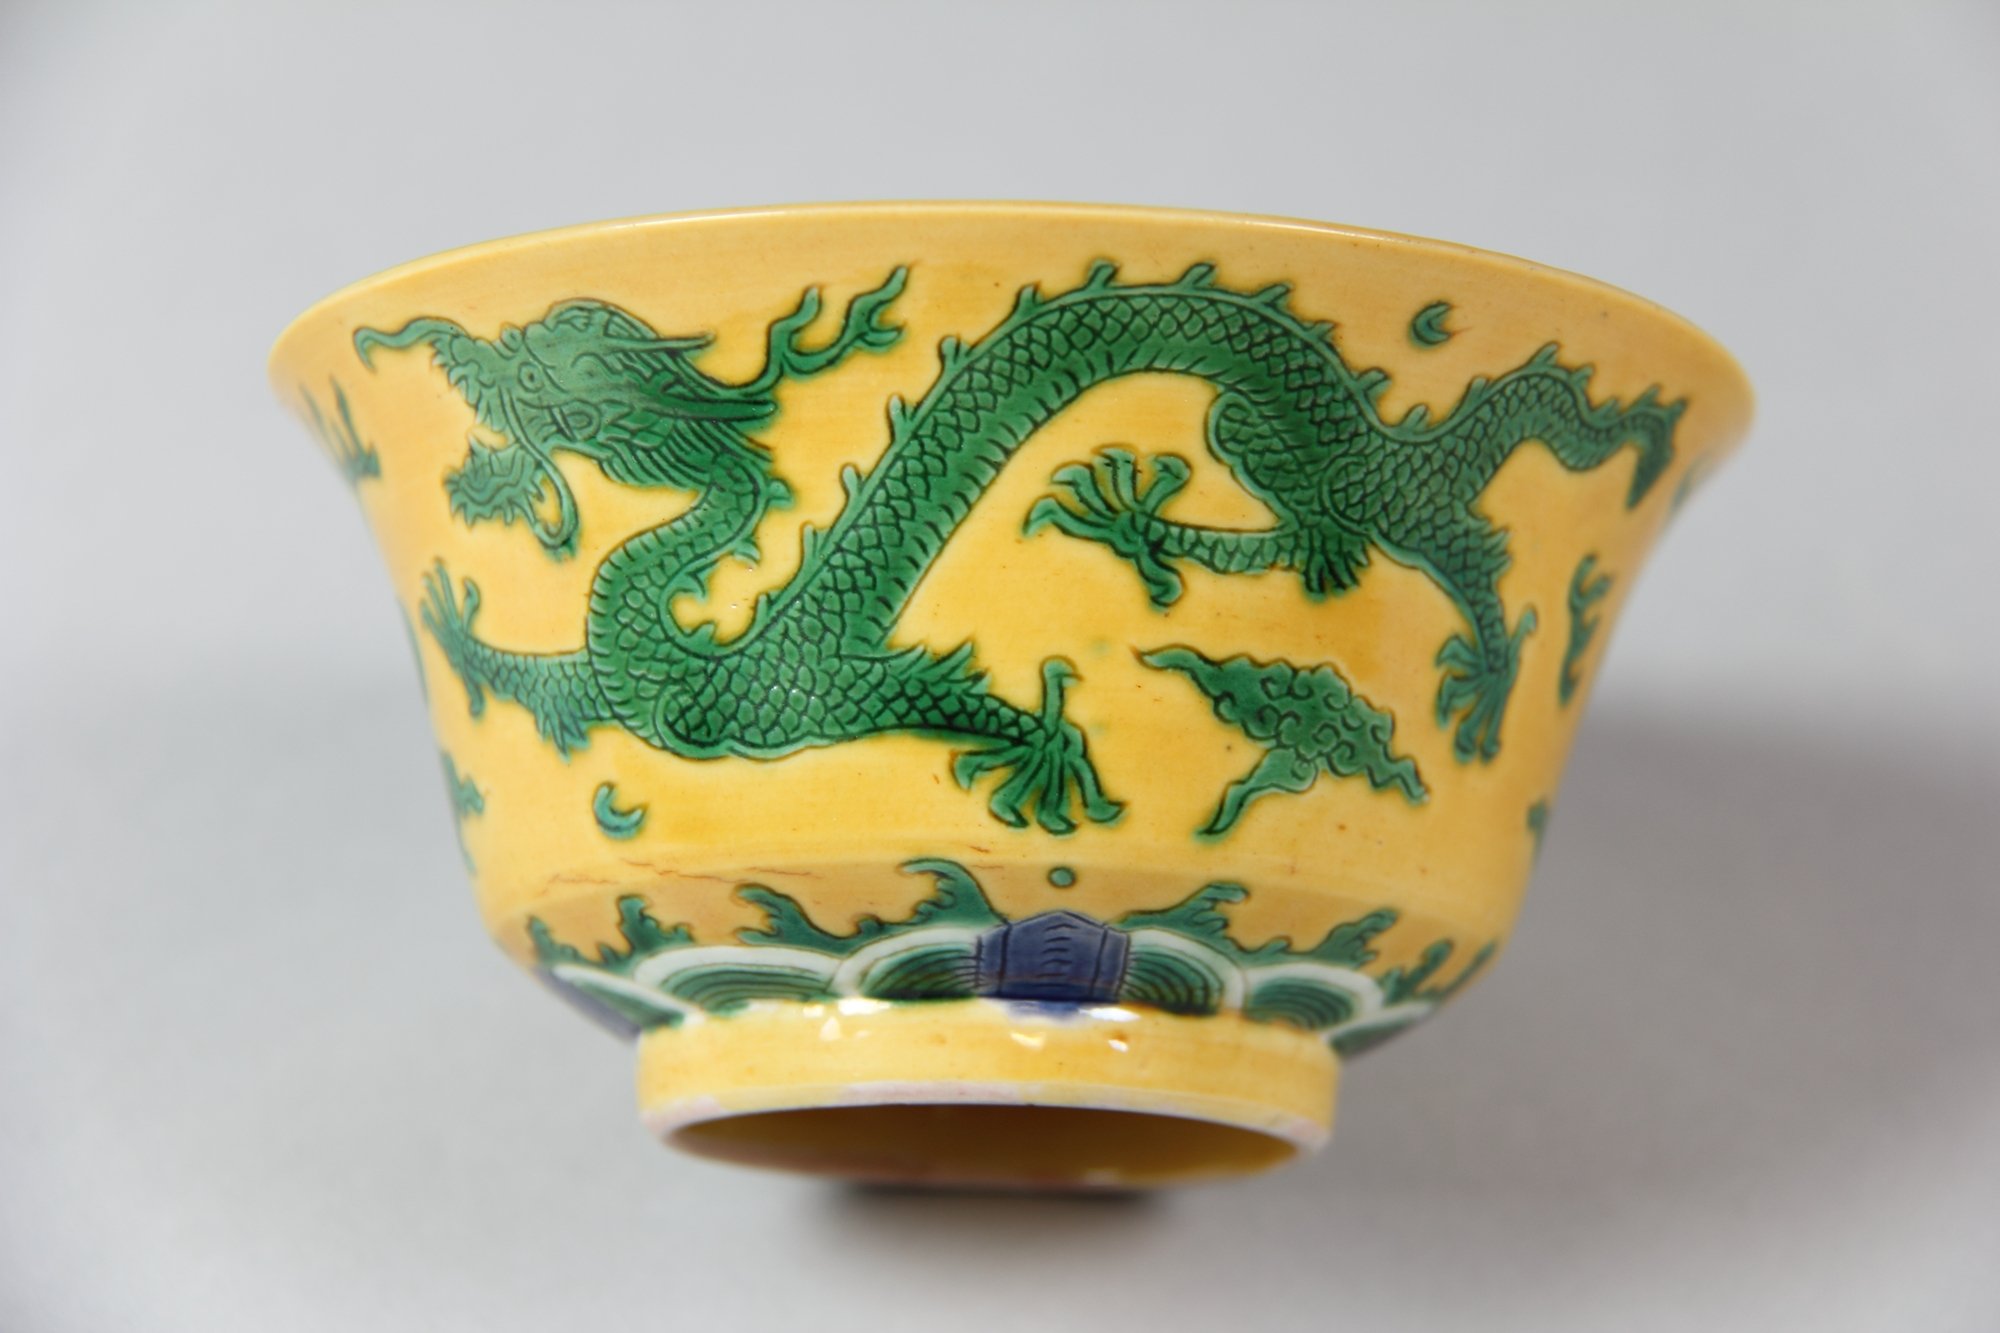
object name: bowl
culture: chinese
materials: glaze, porcelain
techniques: incising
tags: dragons